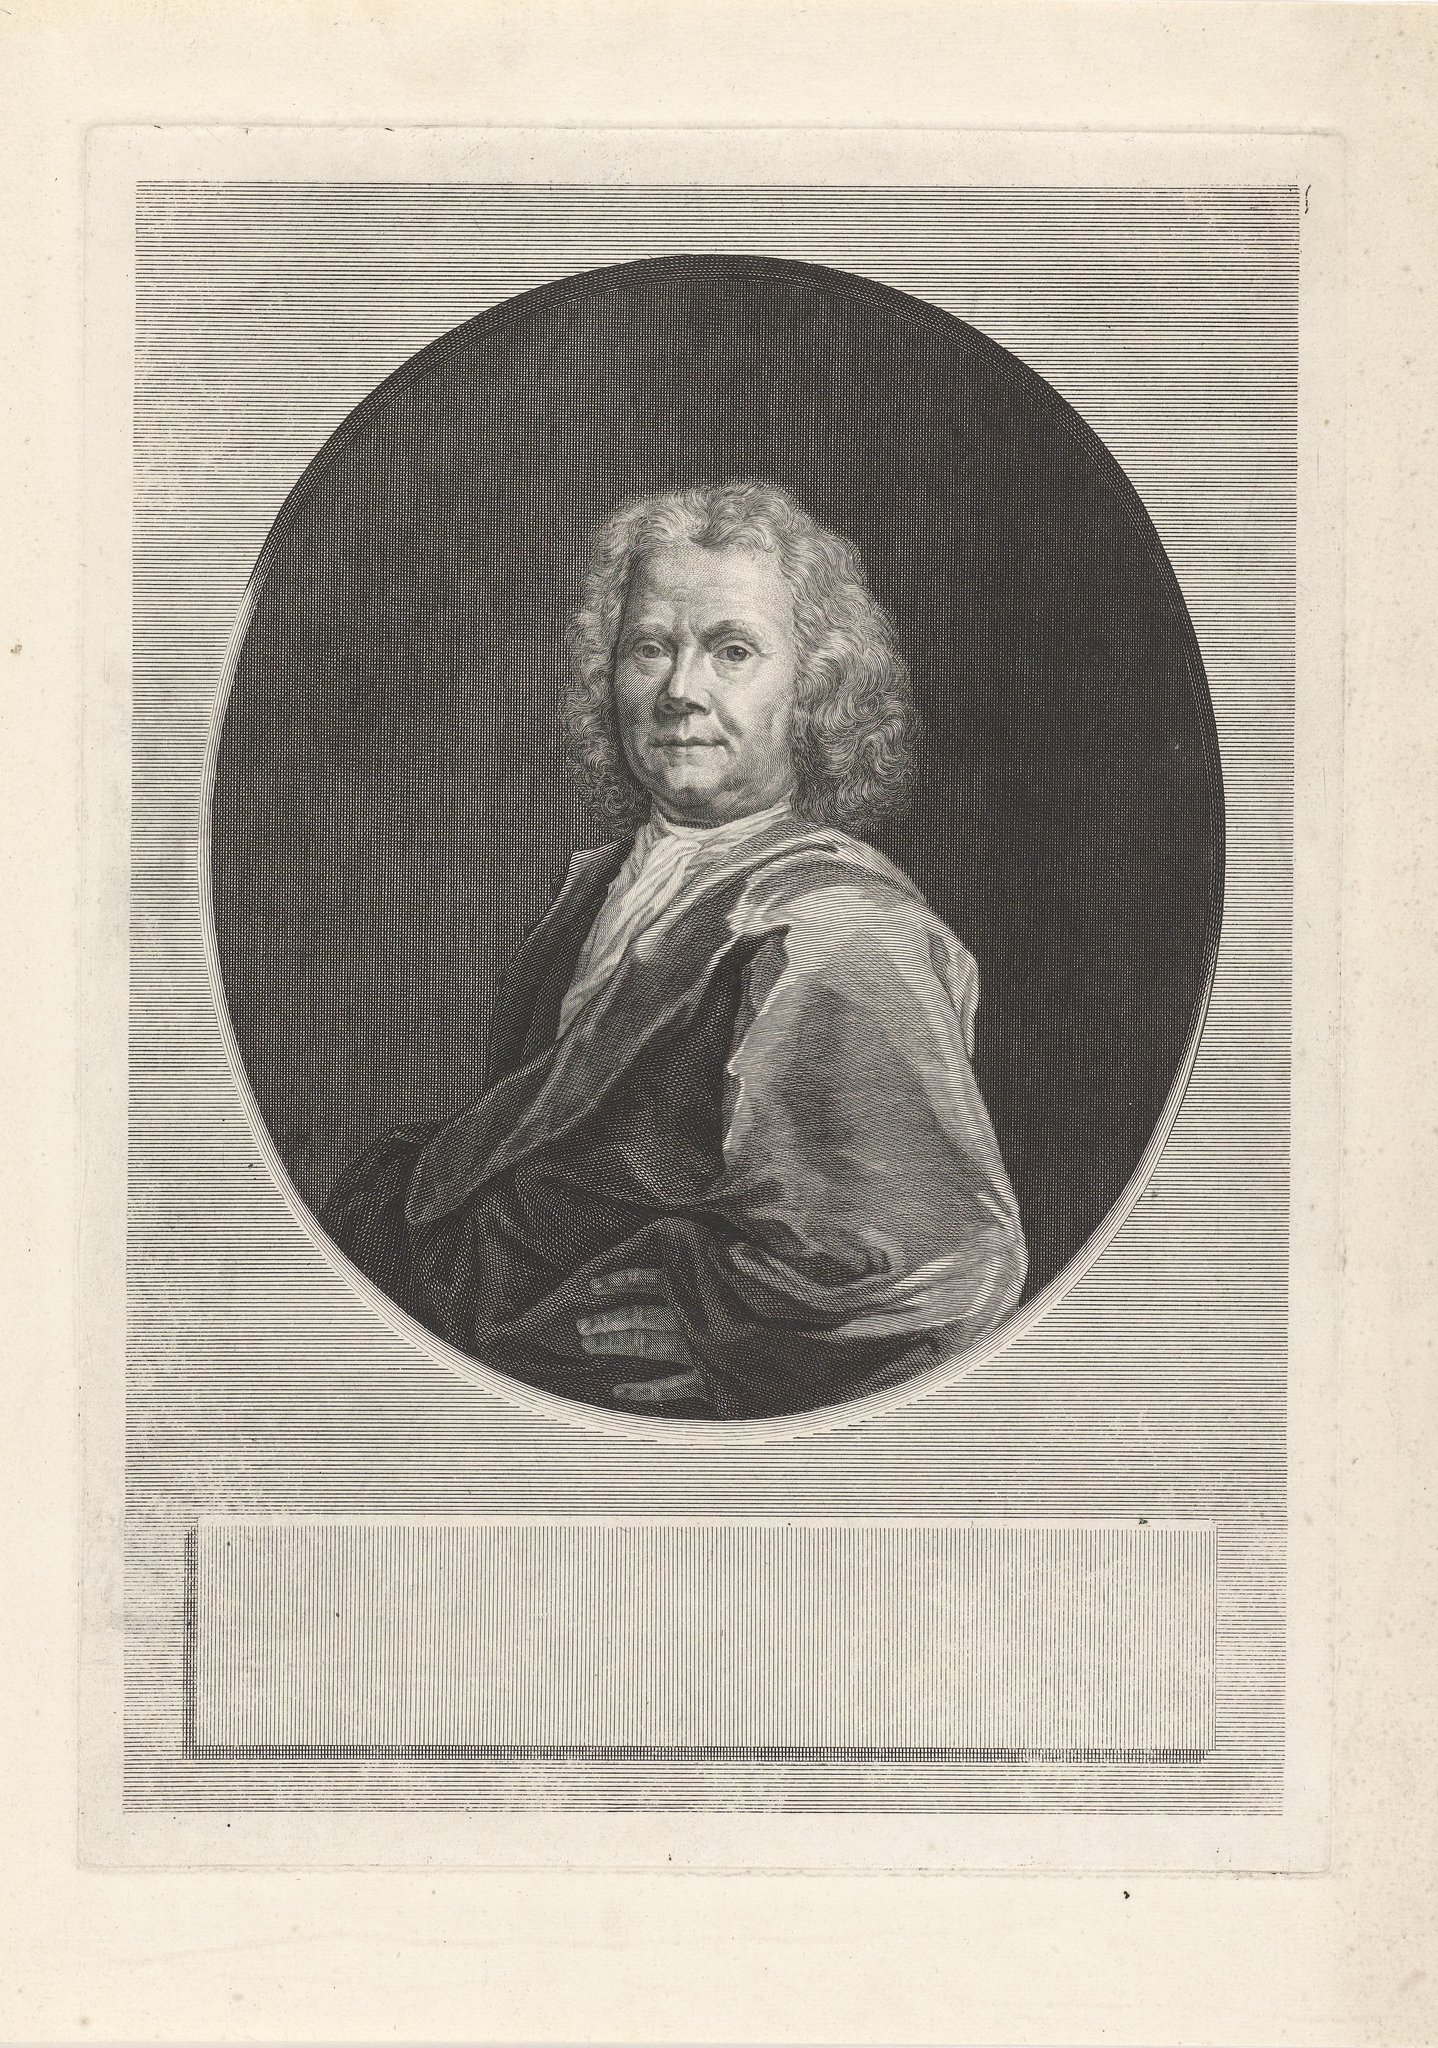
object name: print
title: Portret van Hermanus Boerhaave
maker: johan van der spruyt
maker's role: print maker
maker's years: 1752-1797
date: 1708-1780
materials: paper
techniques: engraving, etching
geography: amsterdam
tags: hermanus boerhaave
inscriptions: collector's mark: Lugt 2228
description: Portret ten halven lijve naar links van Hermanus Boerhaave in een ovaal. Onder het portret een leeg veld voor zijn naam. Kopie naar de prent van J. Houbraken.